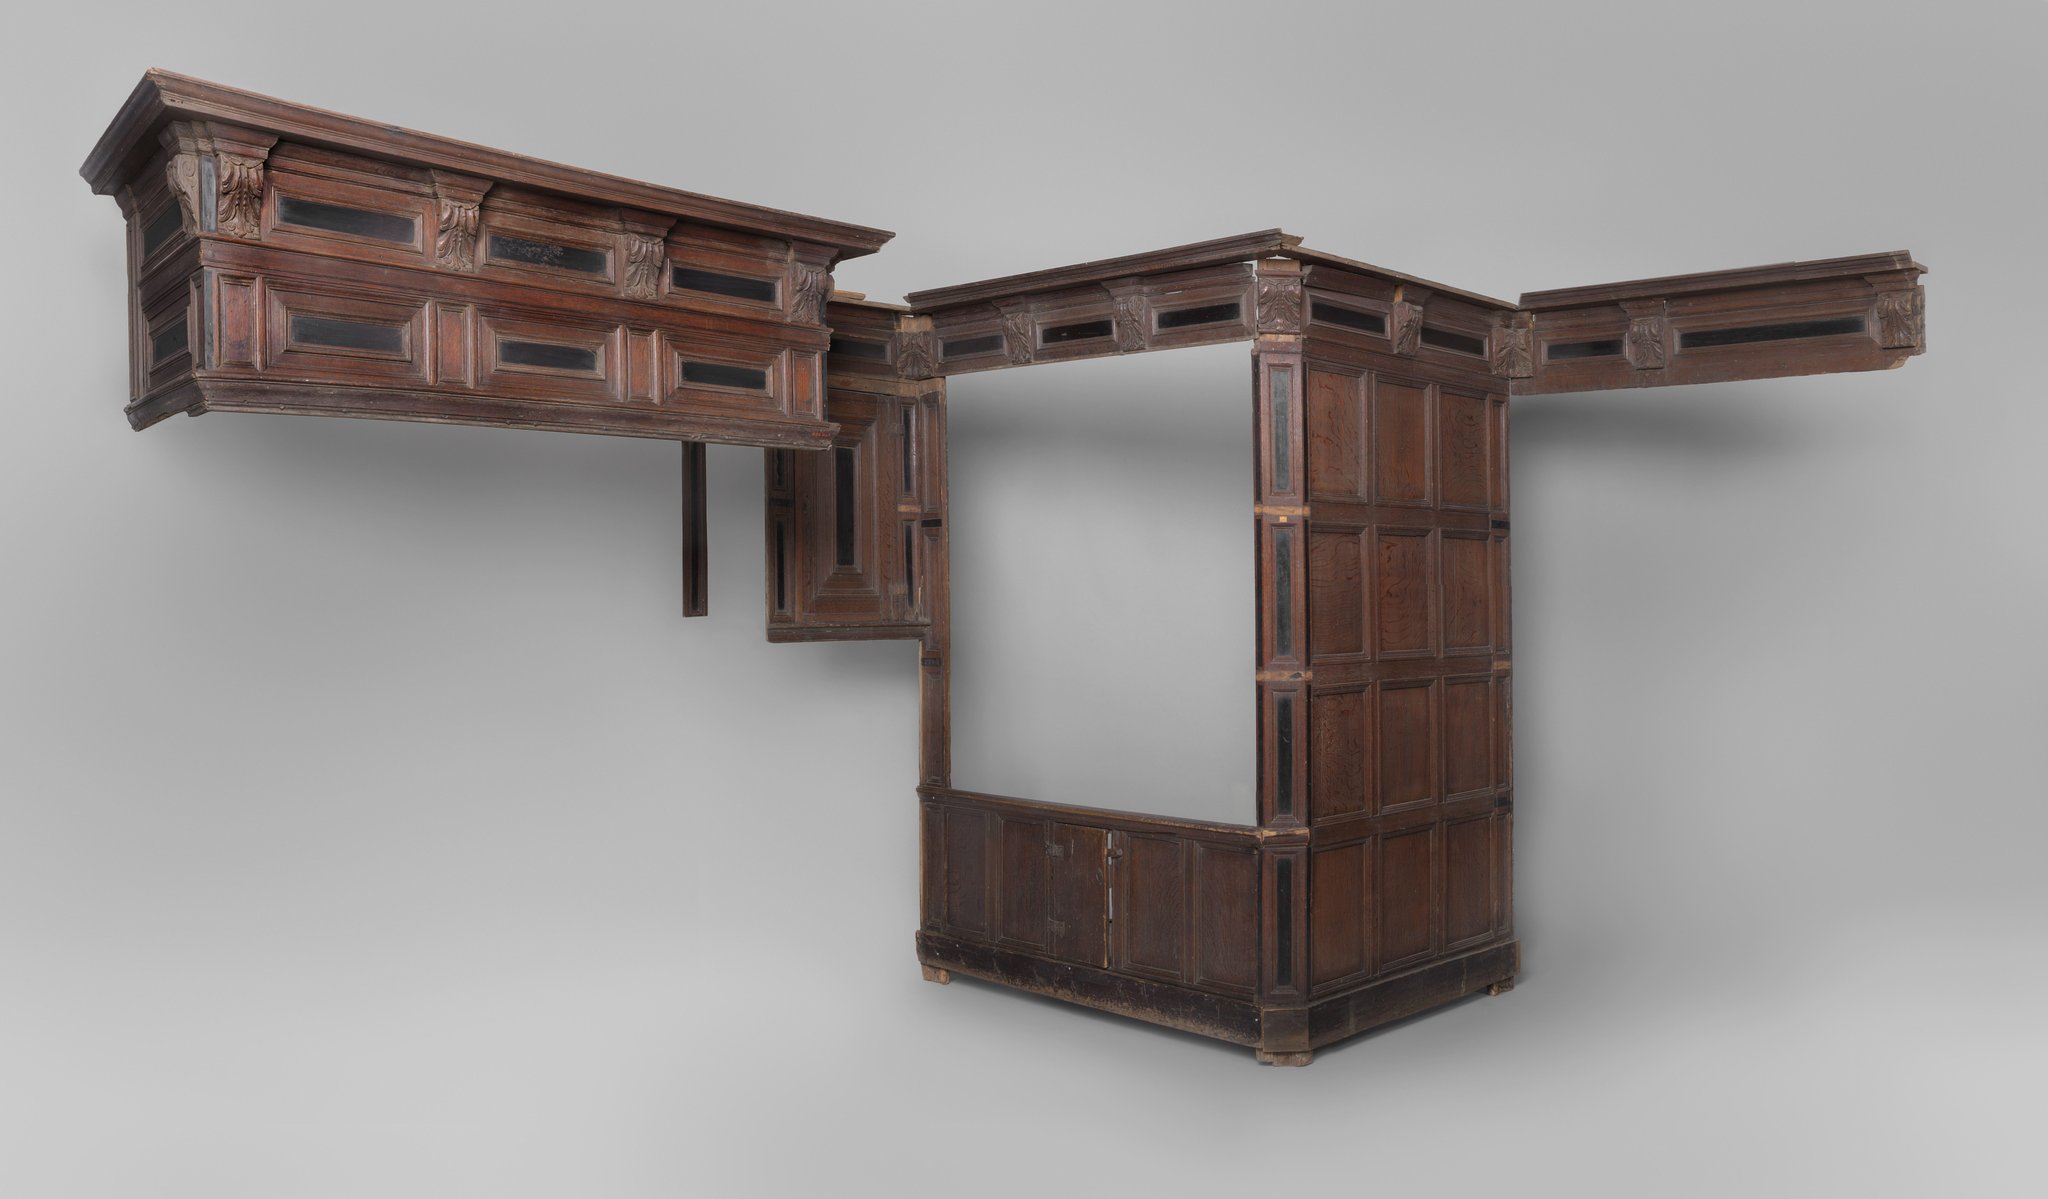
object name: box bed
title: Betimmering met bedstede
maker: Anonymous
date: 1640-1660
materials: wood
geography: netherlands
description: Betimmering van eike- en palissanderhout, bestaande uit een fries dat op gelijke hoogte met de schoorsteenmantel aansluit en verder als kroonlijst met afgeschuinde hoeken om een hoekbedstede is heengetrokken. Totaal 16 onderdelen.